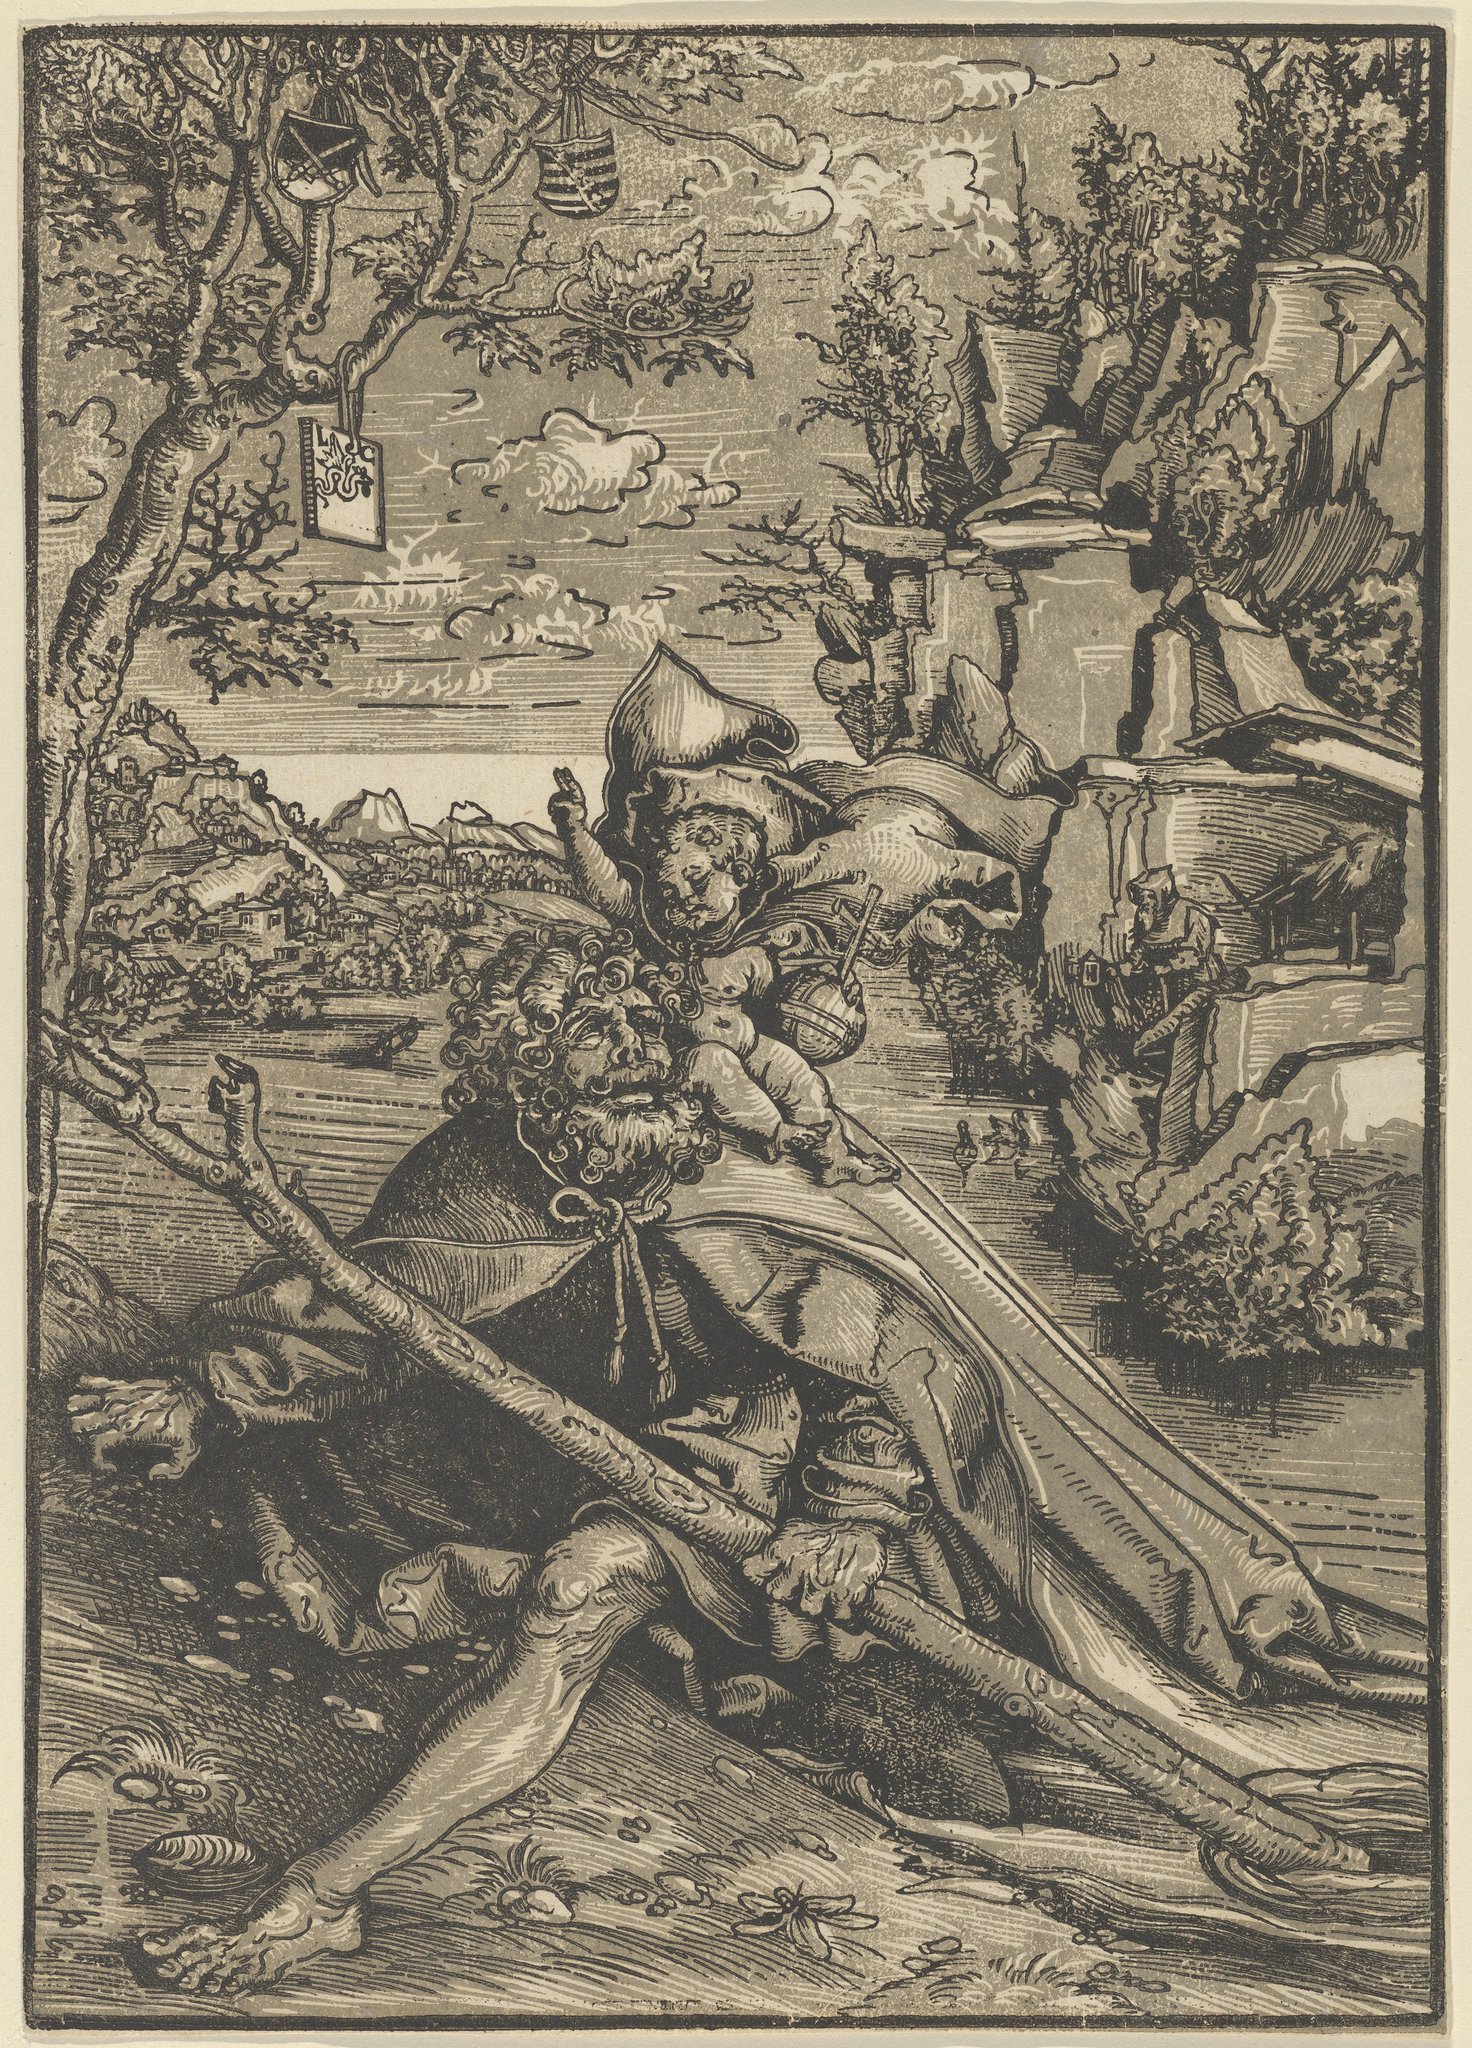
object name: print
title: Saint Christopher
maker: lucas cranach the elder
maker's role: artist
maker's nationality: german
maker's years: 1472-1553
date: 1506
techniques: woodcut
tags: saint christopher